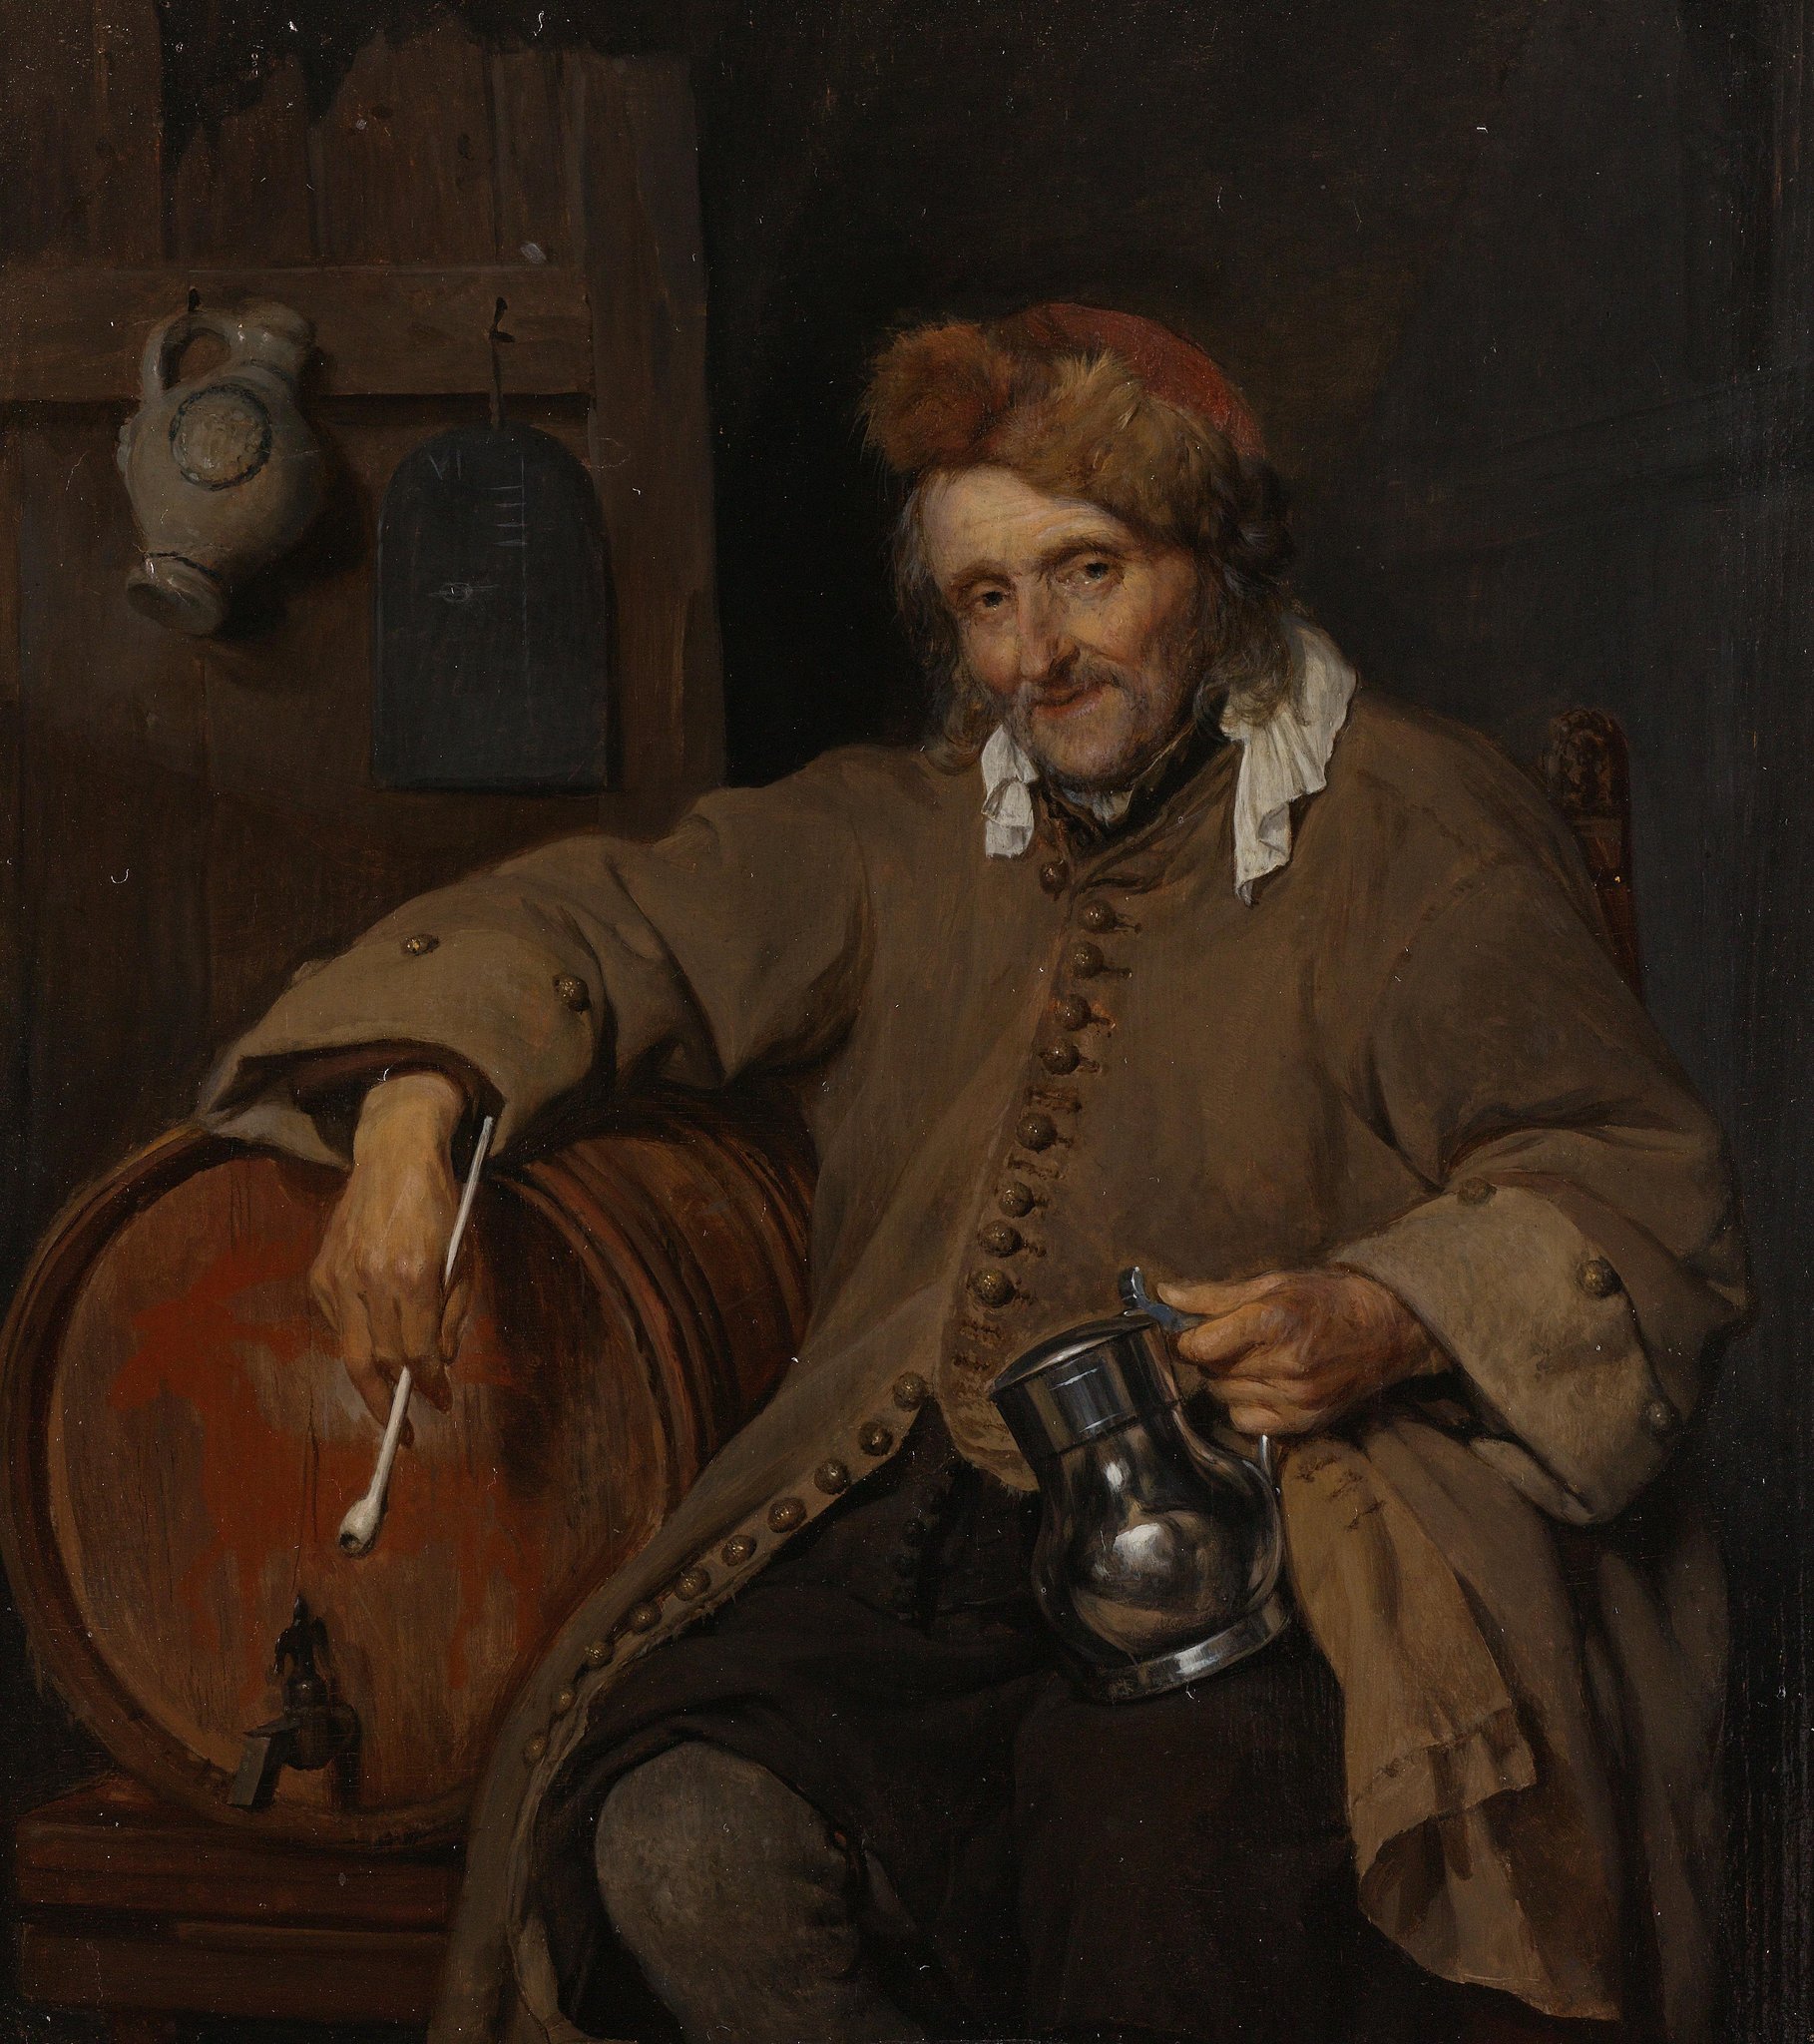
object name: painting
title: The Old Drinker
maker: gabriël metsu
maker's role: draughtsman, painter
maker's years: 1629-1667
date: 1661-1663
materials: oil, panel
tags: pipe ~ tobacco, old man, drinking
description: This old man holding a beer tankard looks out at us somewhat drowsily. The tally of the drinks he has consumed is chalked up on the slate behind him. The beer barrel at the left bears the mark of Het Rode Hert (The Red Hart), an Amsterdam brewery on the Prinsengracht. Metsu was living next door to it around 1650.